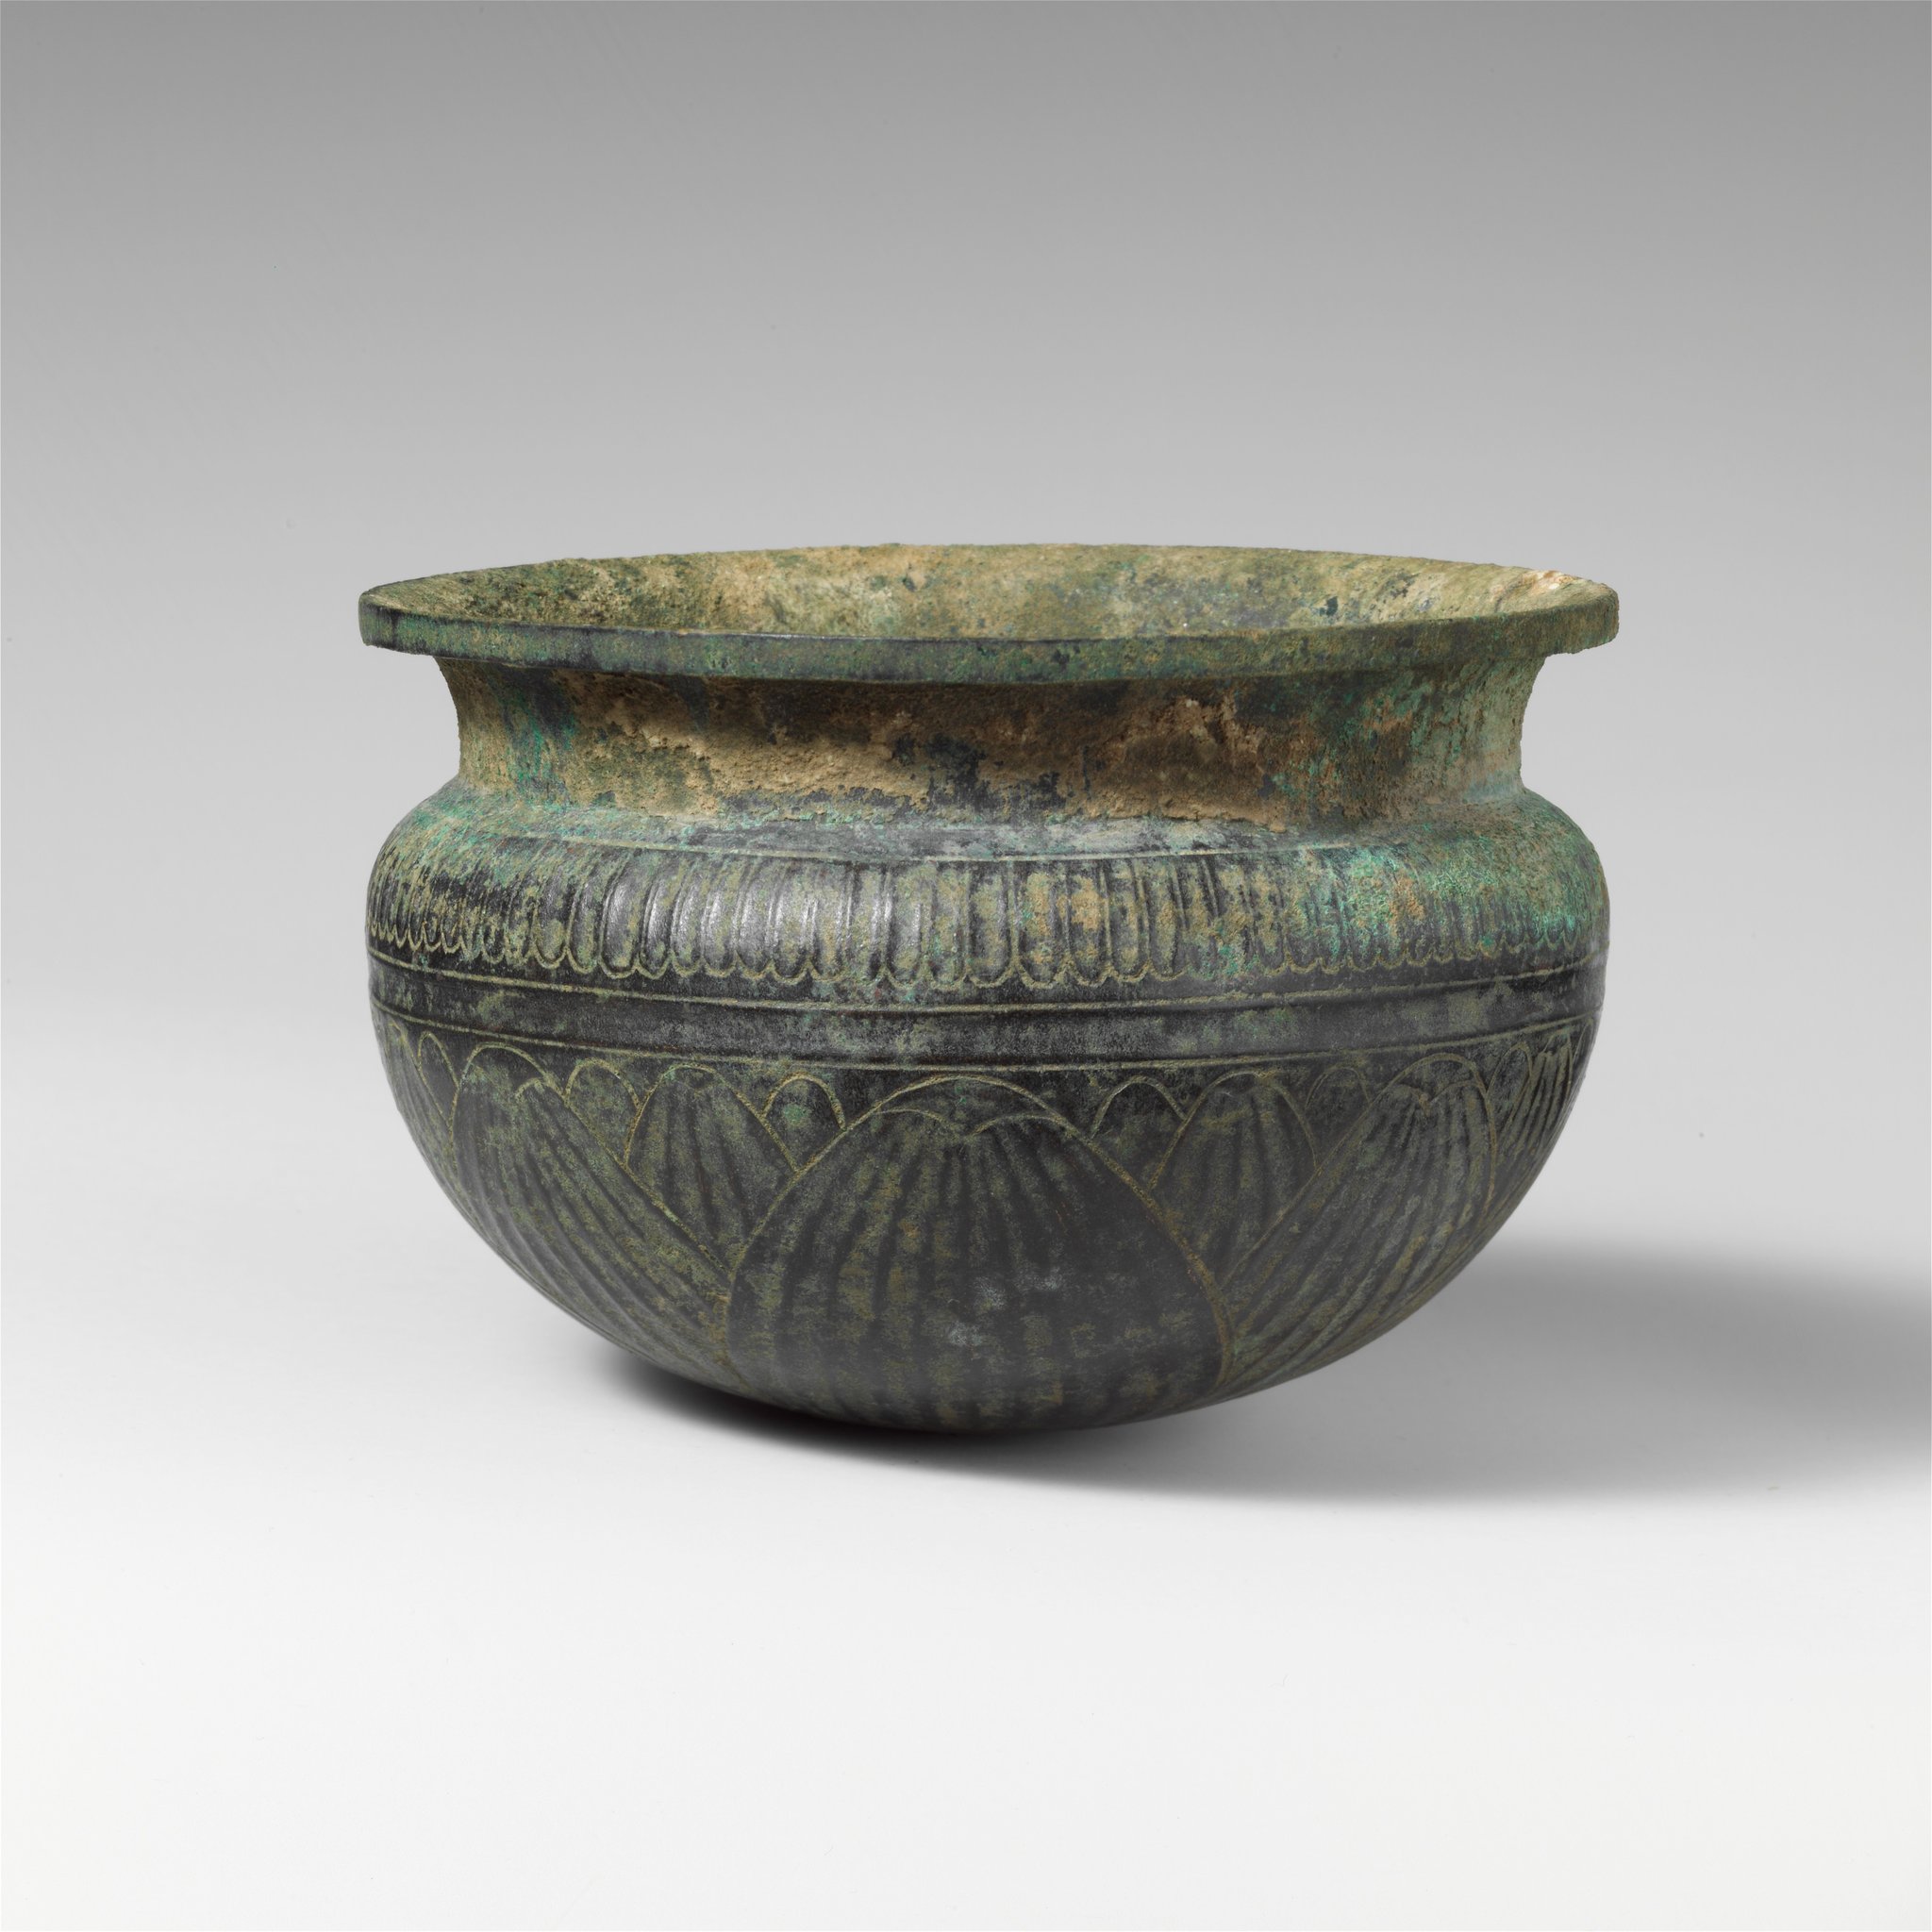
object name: bowl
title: Bronze bowl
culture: greek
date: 500-301 BCE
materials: bronze